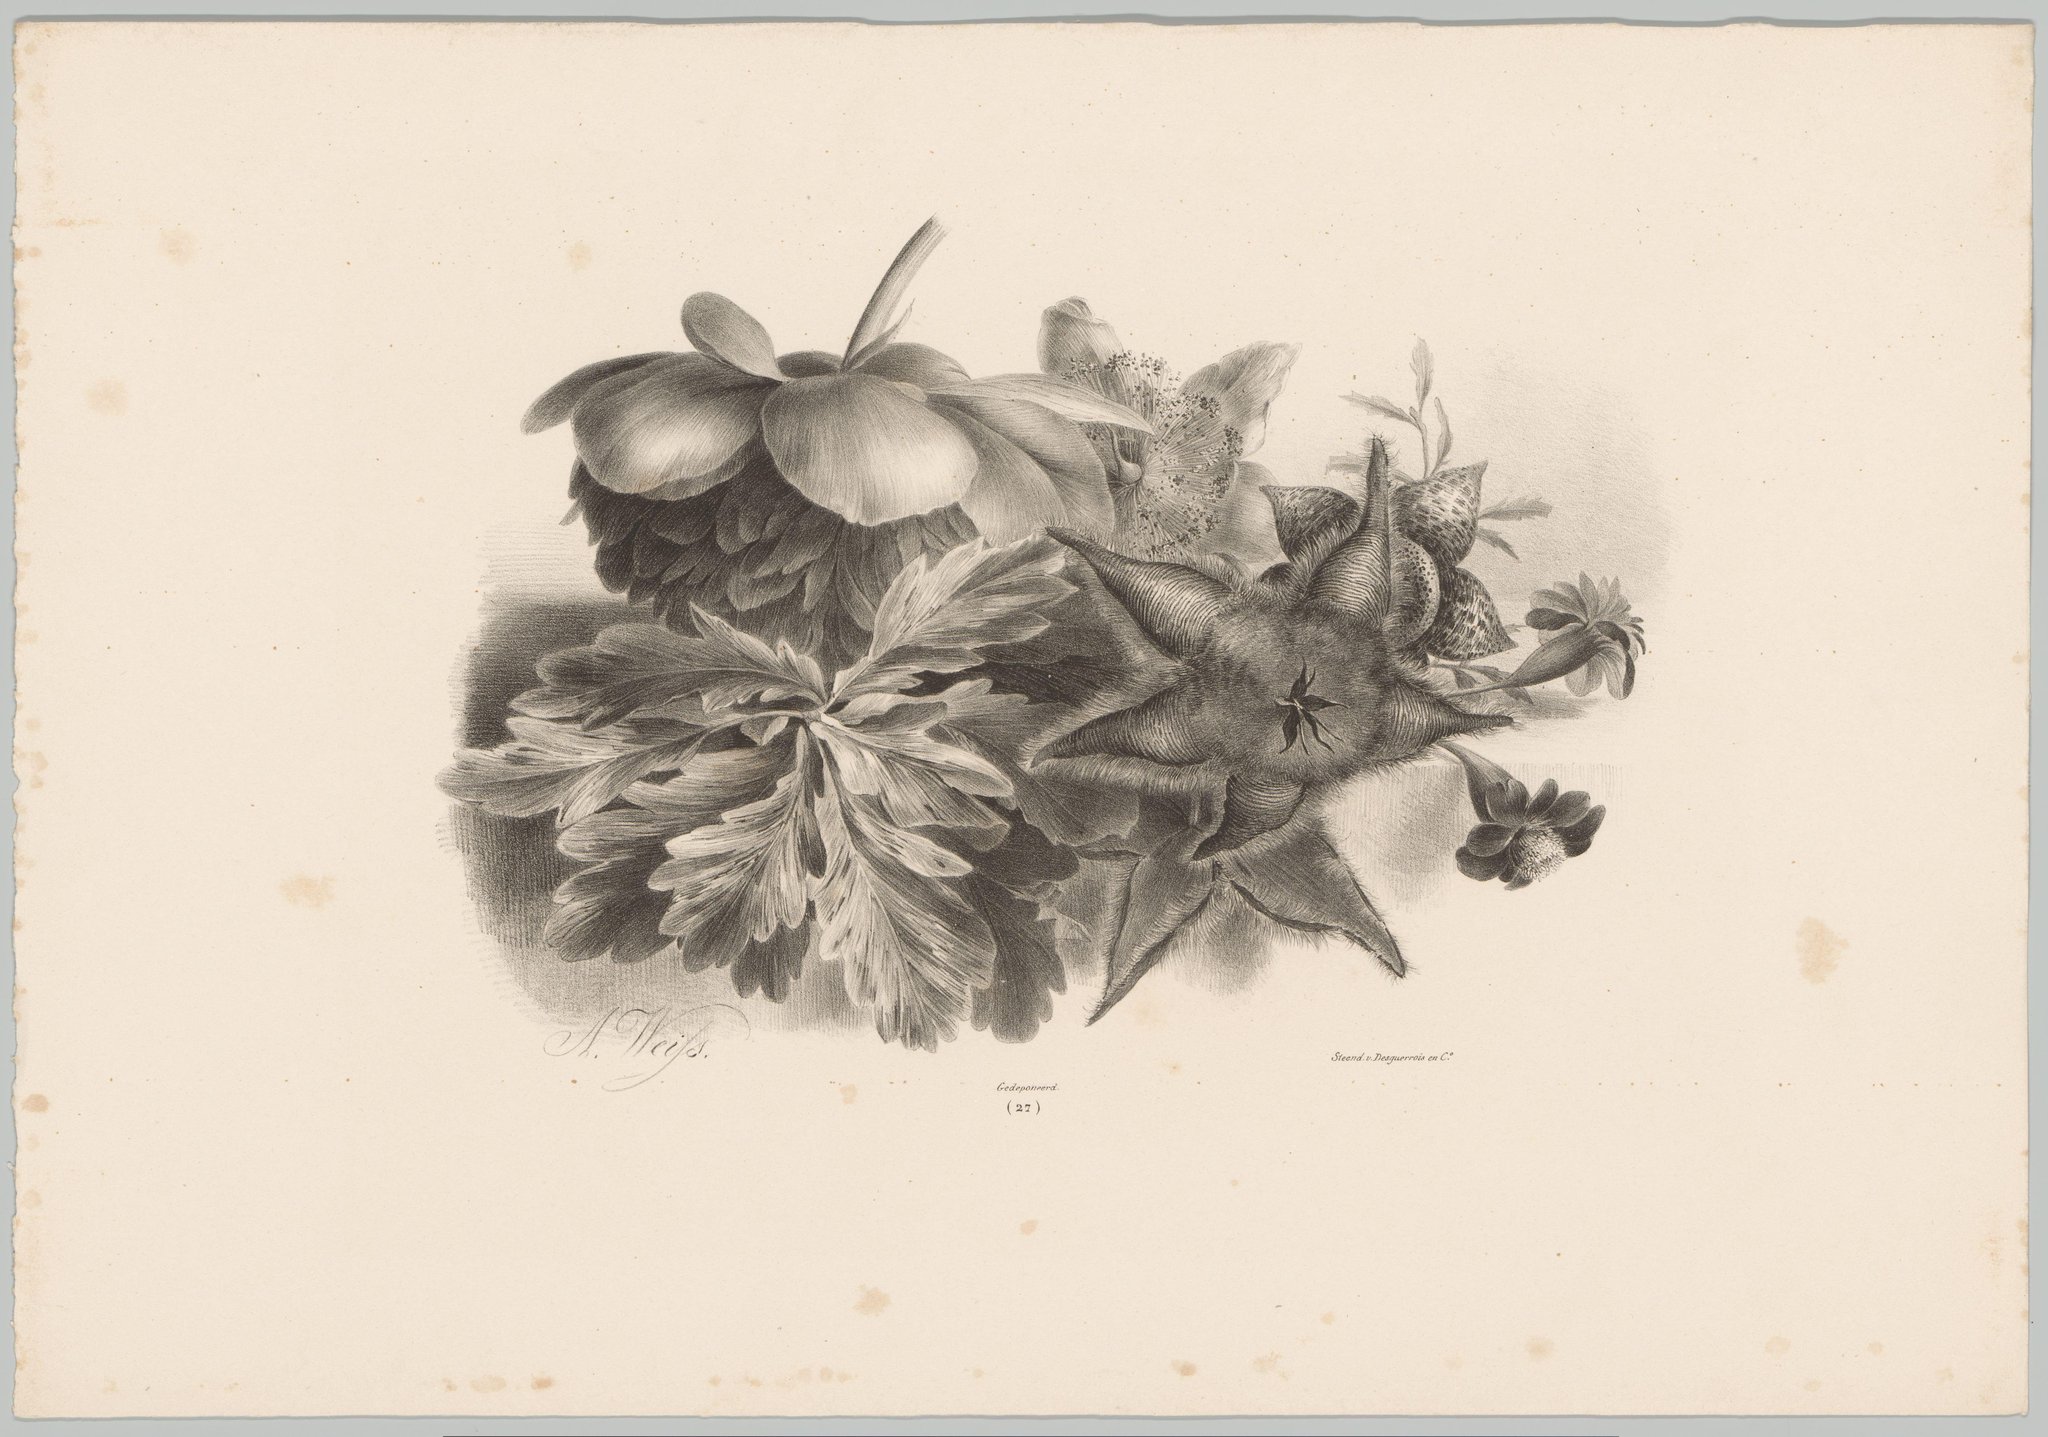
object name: print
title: Passiebloemen en bladeren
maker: anton weiss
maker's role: draughtsman, print maker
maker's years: 1801-1851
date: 1836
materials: paper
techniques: lithograph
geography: amsterdam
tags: flowers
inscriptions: : ‘Gedeponeerd.’, collector's mark: Lugt 2228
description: Onderdeel van een omslag met een serie van eenenveertig lithografieën van bloemen en fruit.